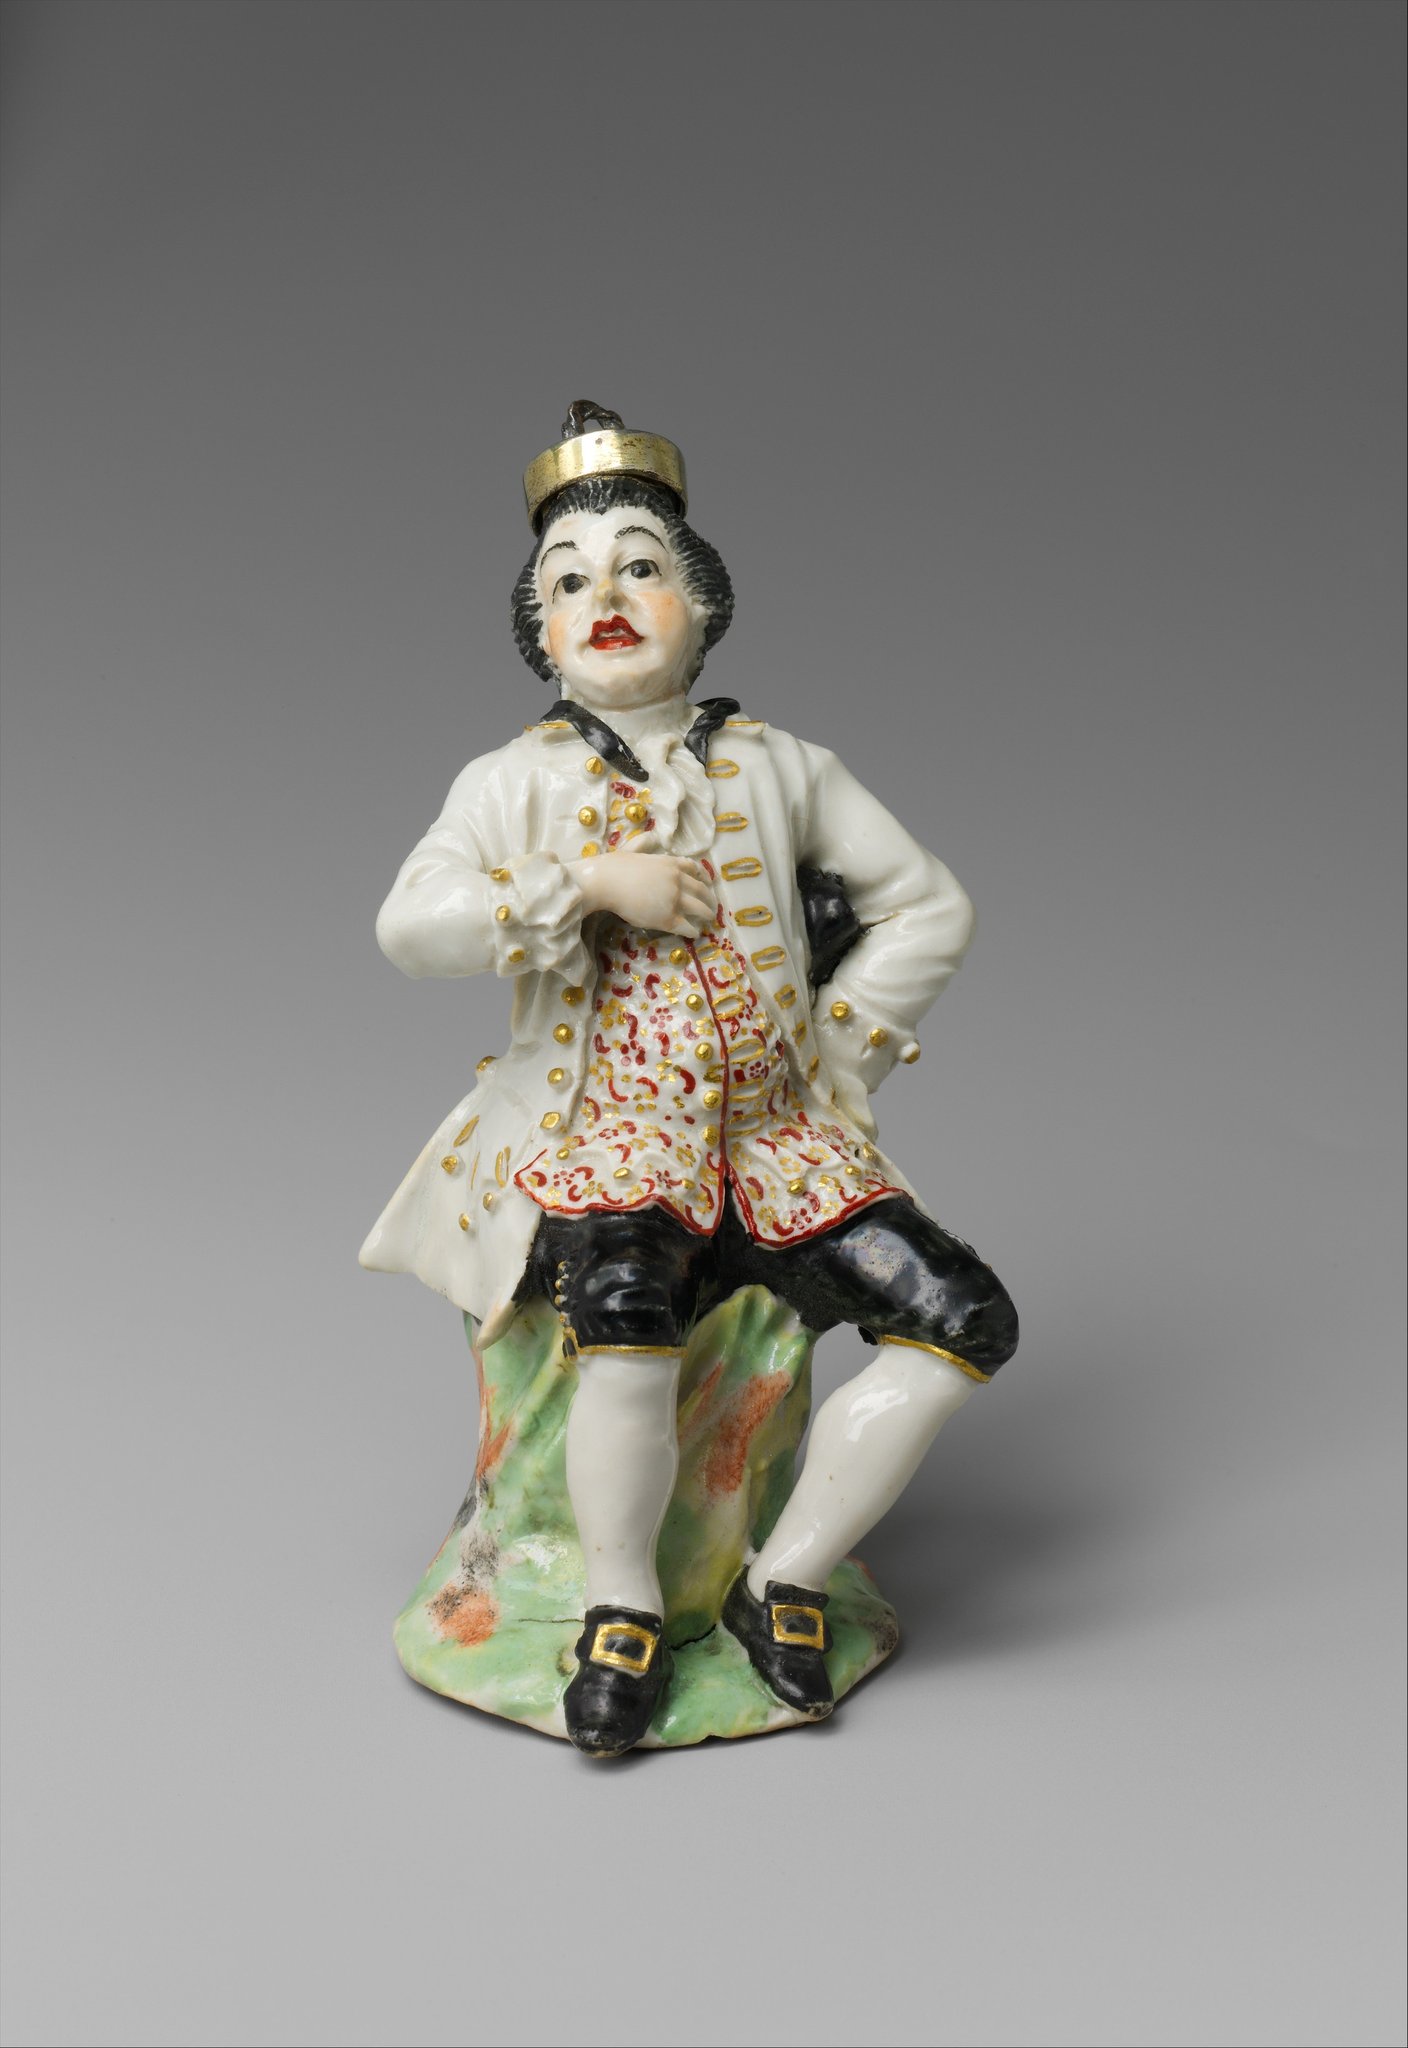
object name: scent bottle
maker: kelsterbach pottery and porcelain manufactory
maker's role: manufactory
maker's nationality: german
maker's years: 1758-1828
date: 1755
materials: hard paste porcelain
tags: men